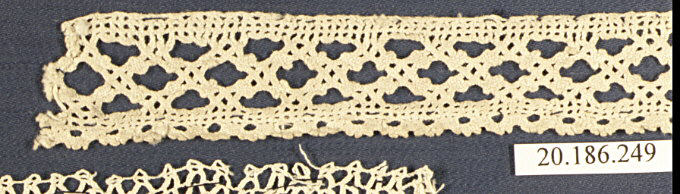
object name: insertion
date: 1501-1600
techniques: lace